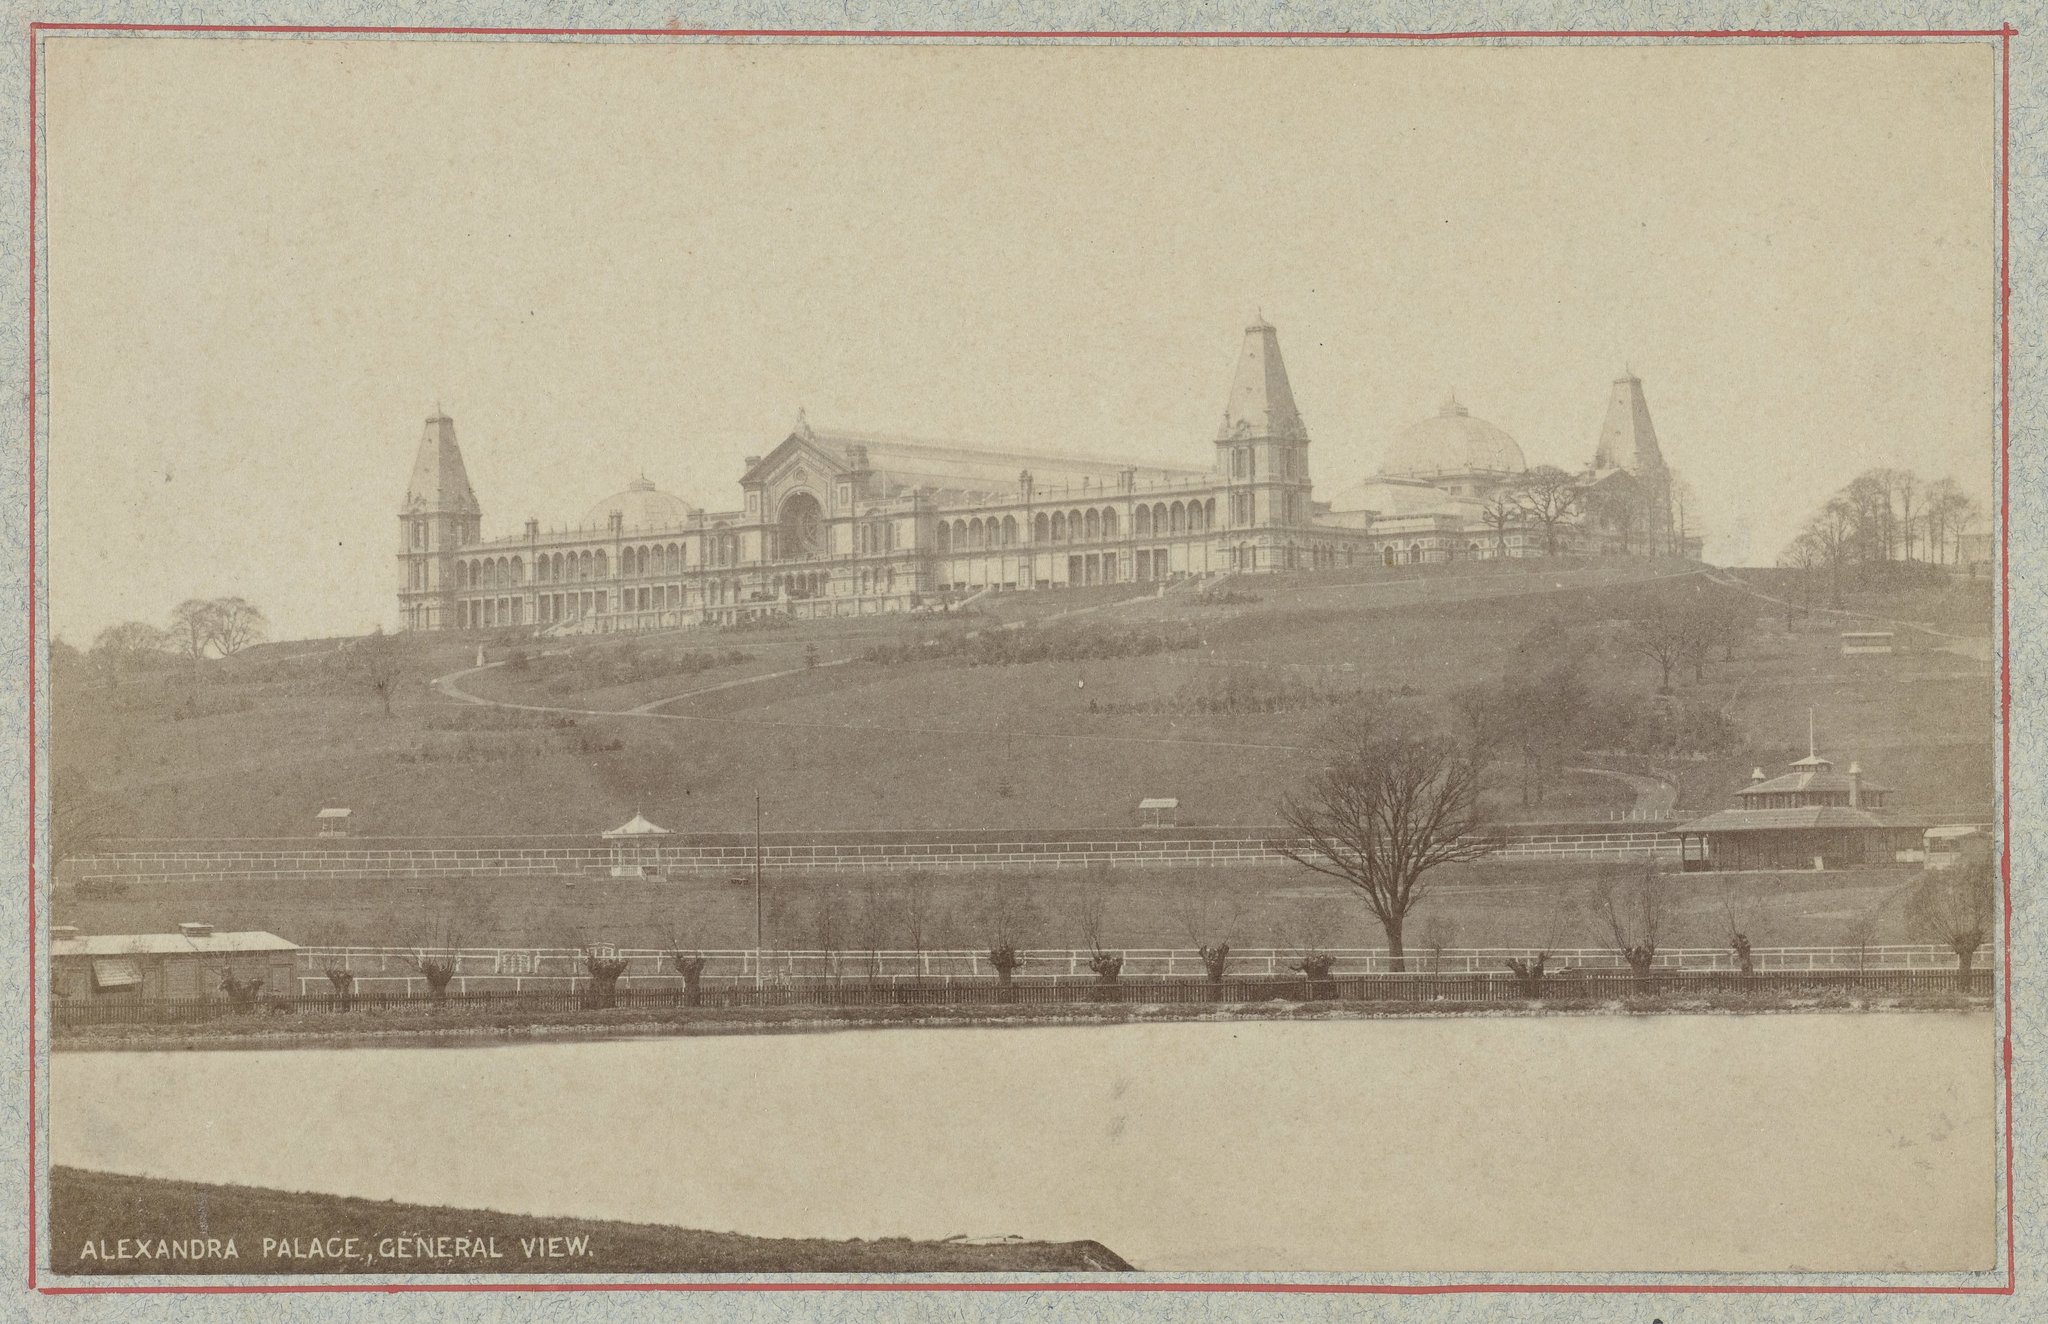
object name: photograph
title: Alexandra Palace, general view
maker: francis godolphin osbourne stuart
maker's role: fotograaf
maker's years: 1843-1923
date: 1873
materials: cardboard, paper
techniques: albumen print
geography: london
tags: palace